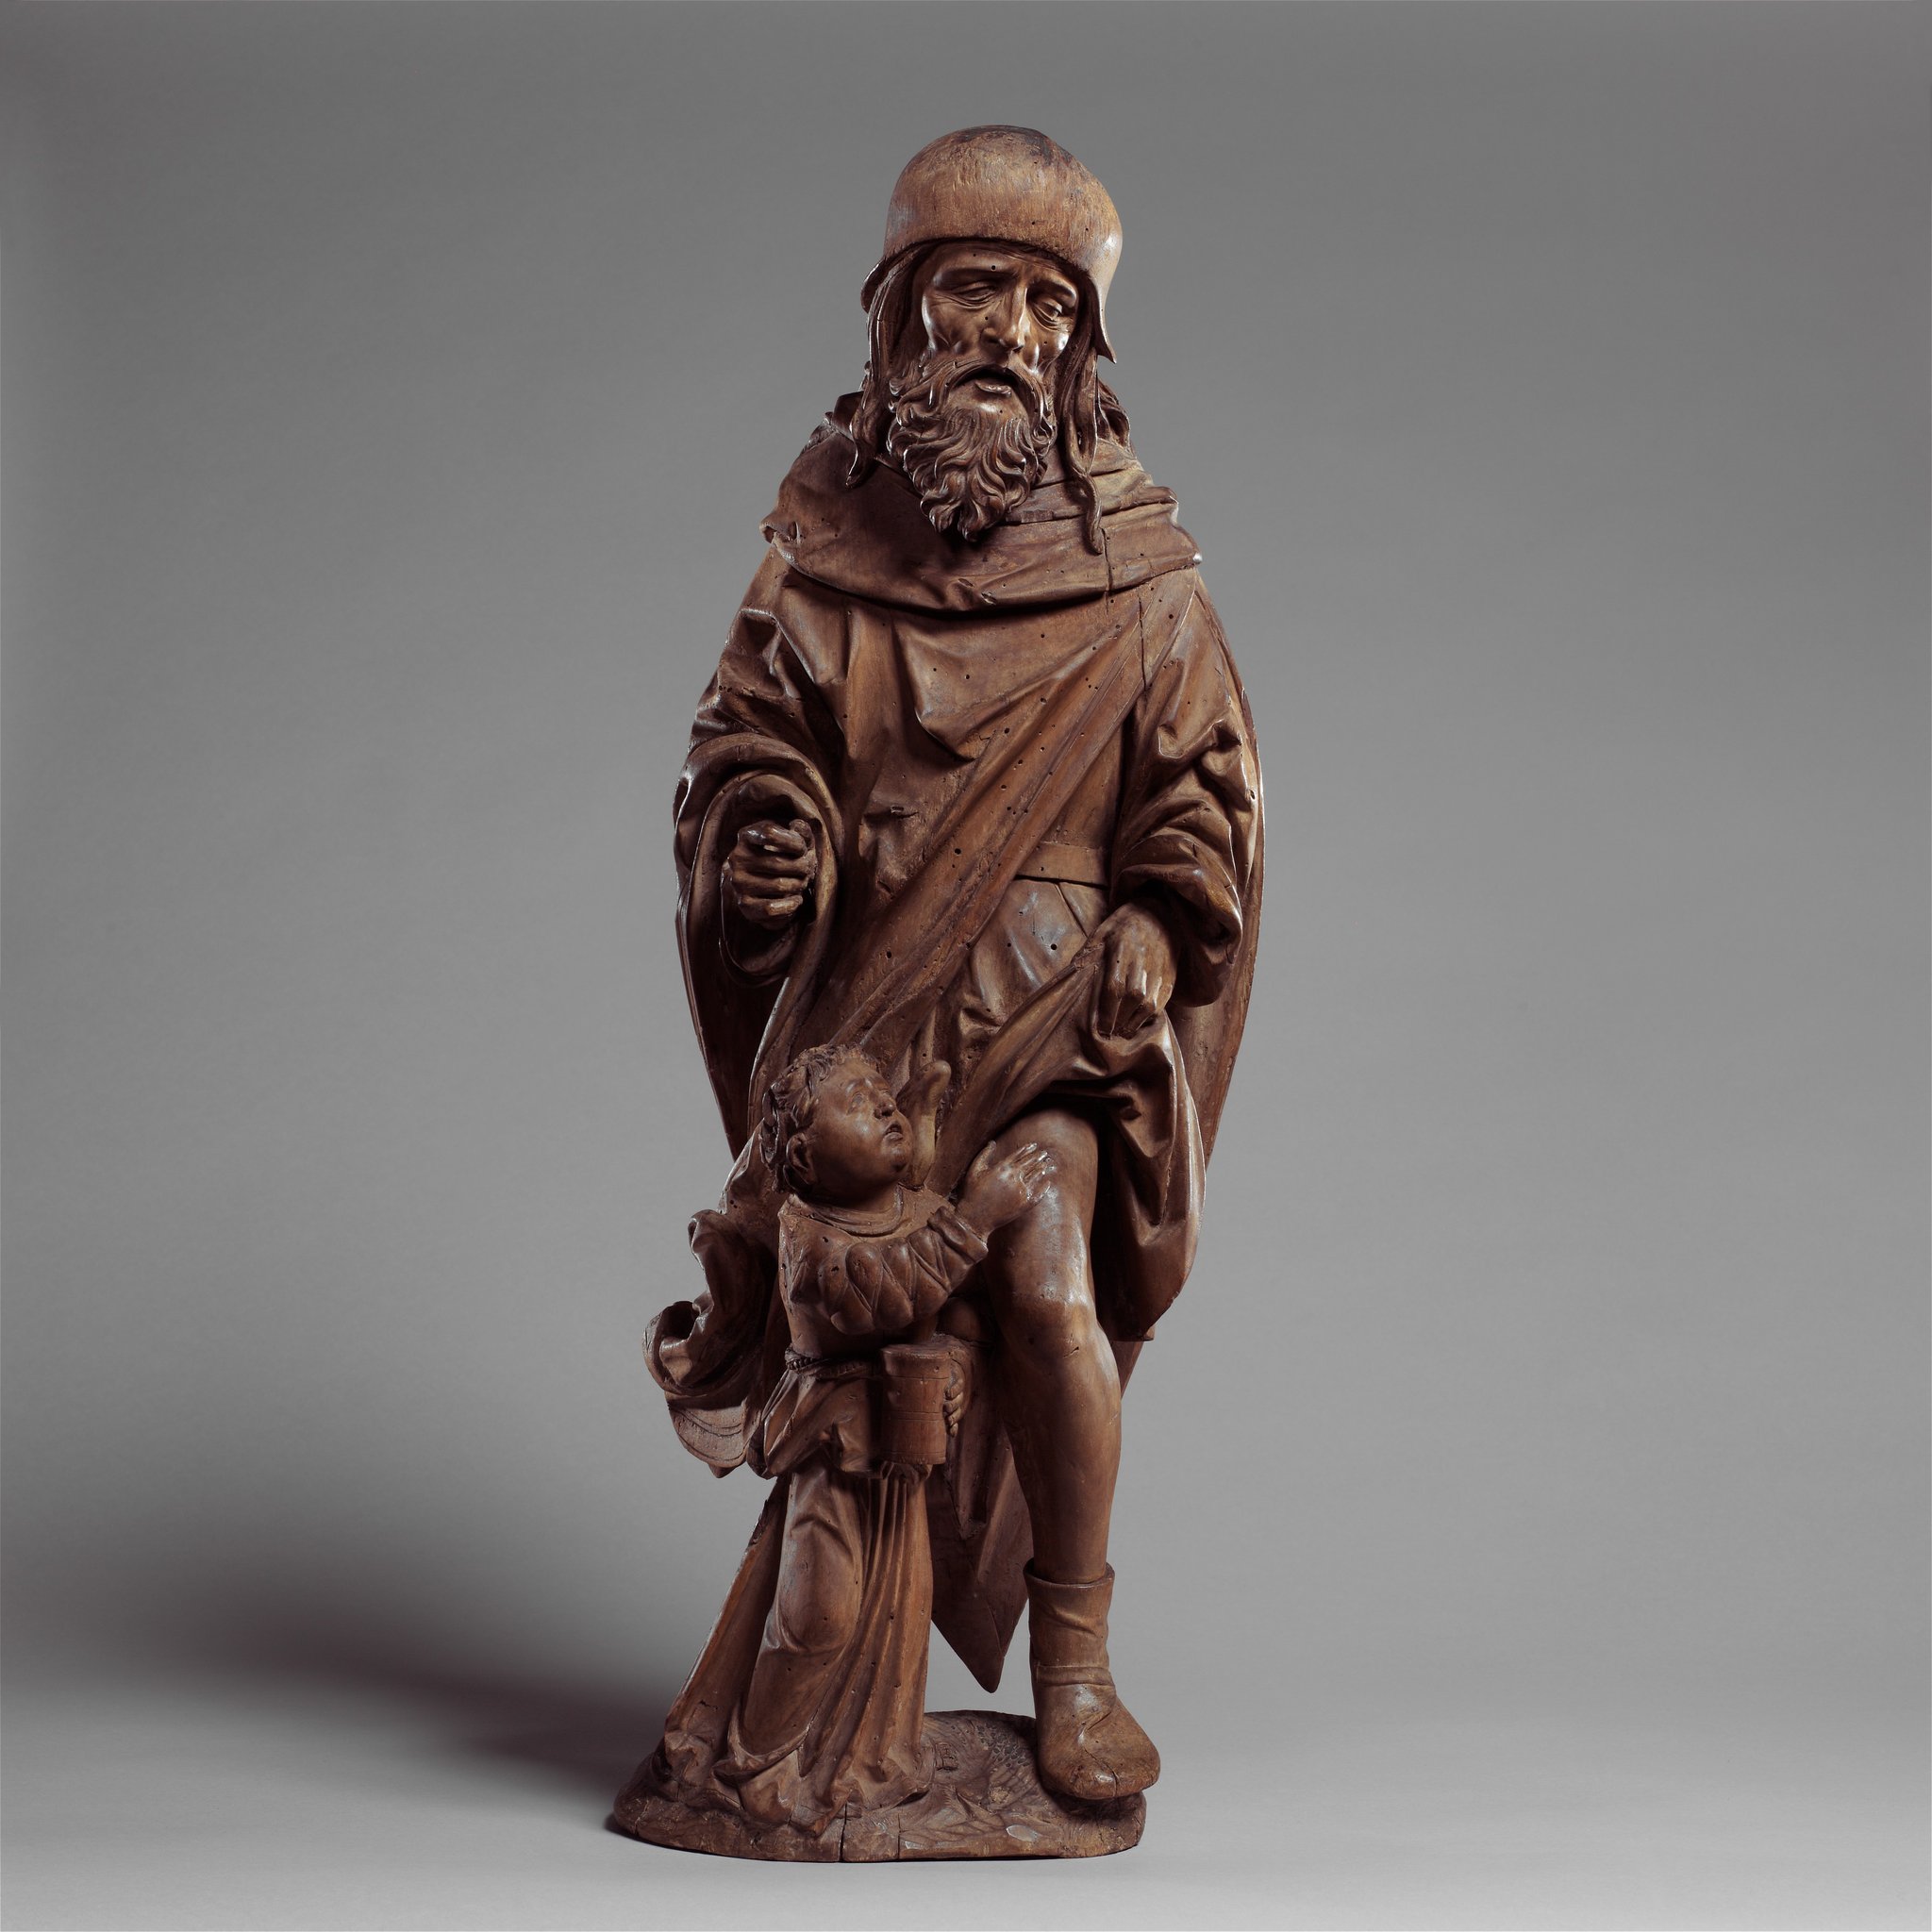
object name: statuette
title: Saint Roch and the Angel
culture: german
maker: master of the biberach holy kinship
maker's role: artist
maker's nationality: german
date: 1520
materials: paint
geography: germany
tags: men,angels,saints